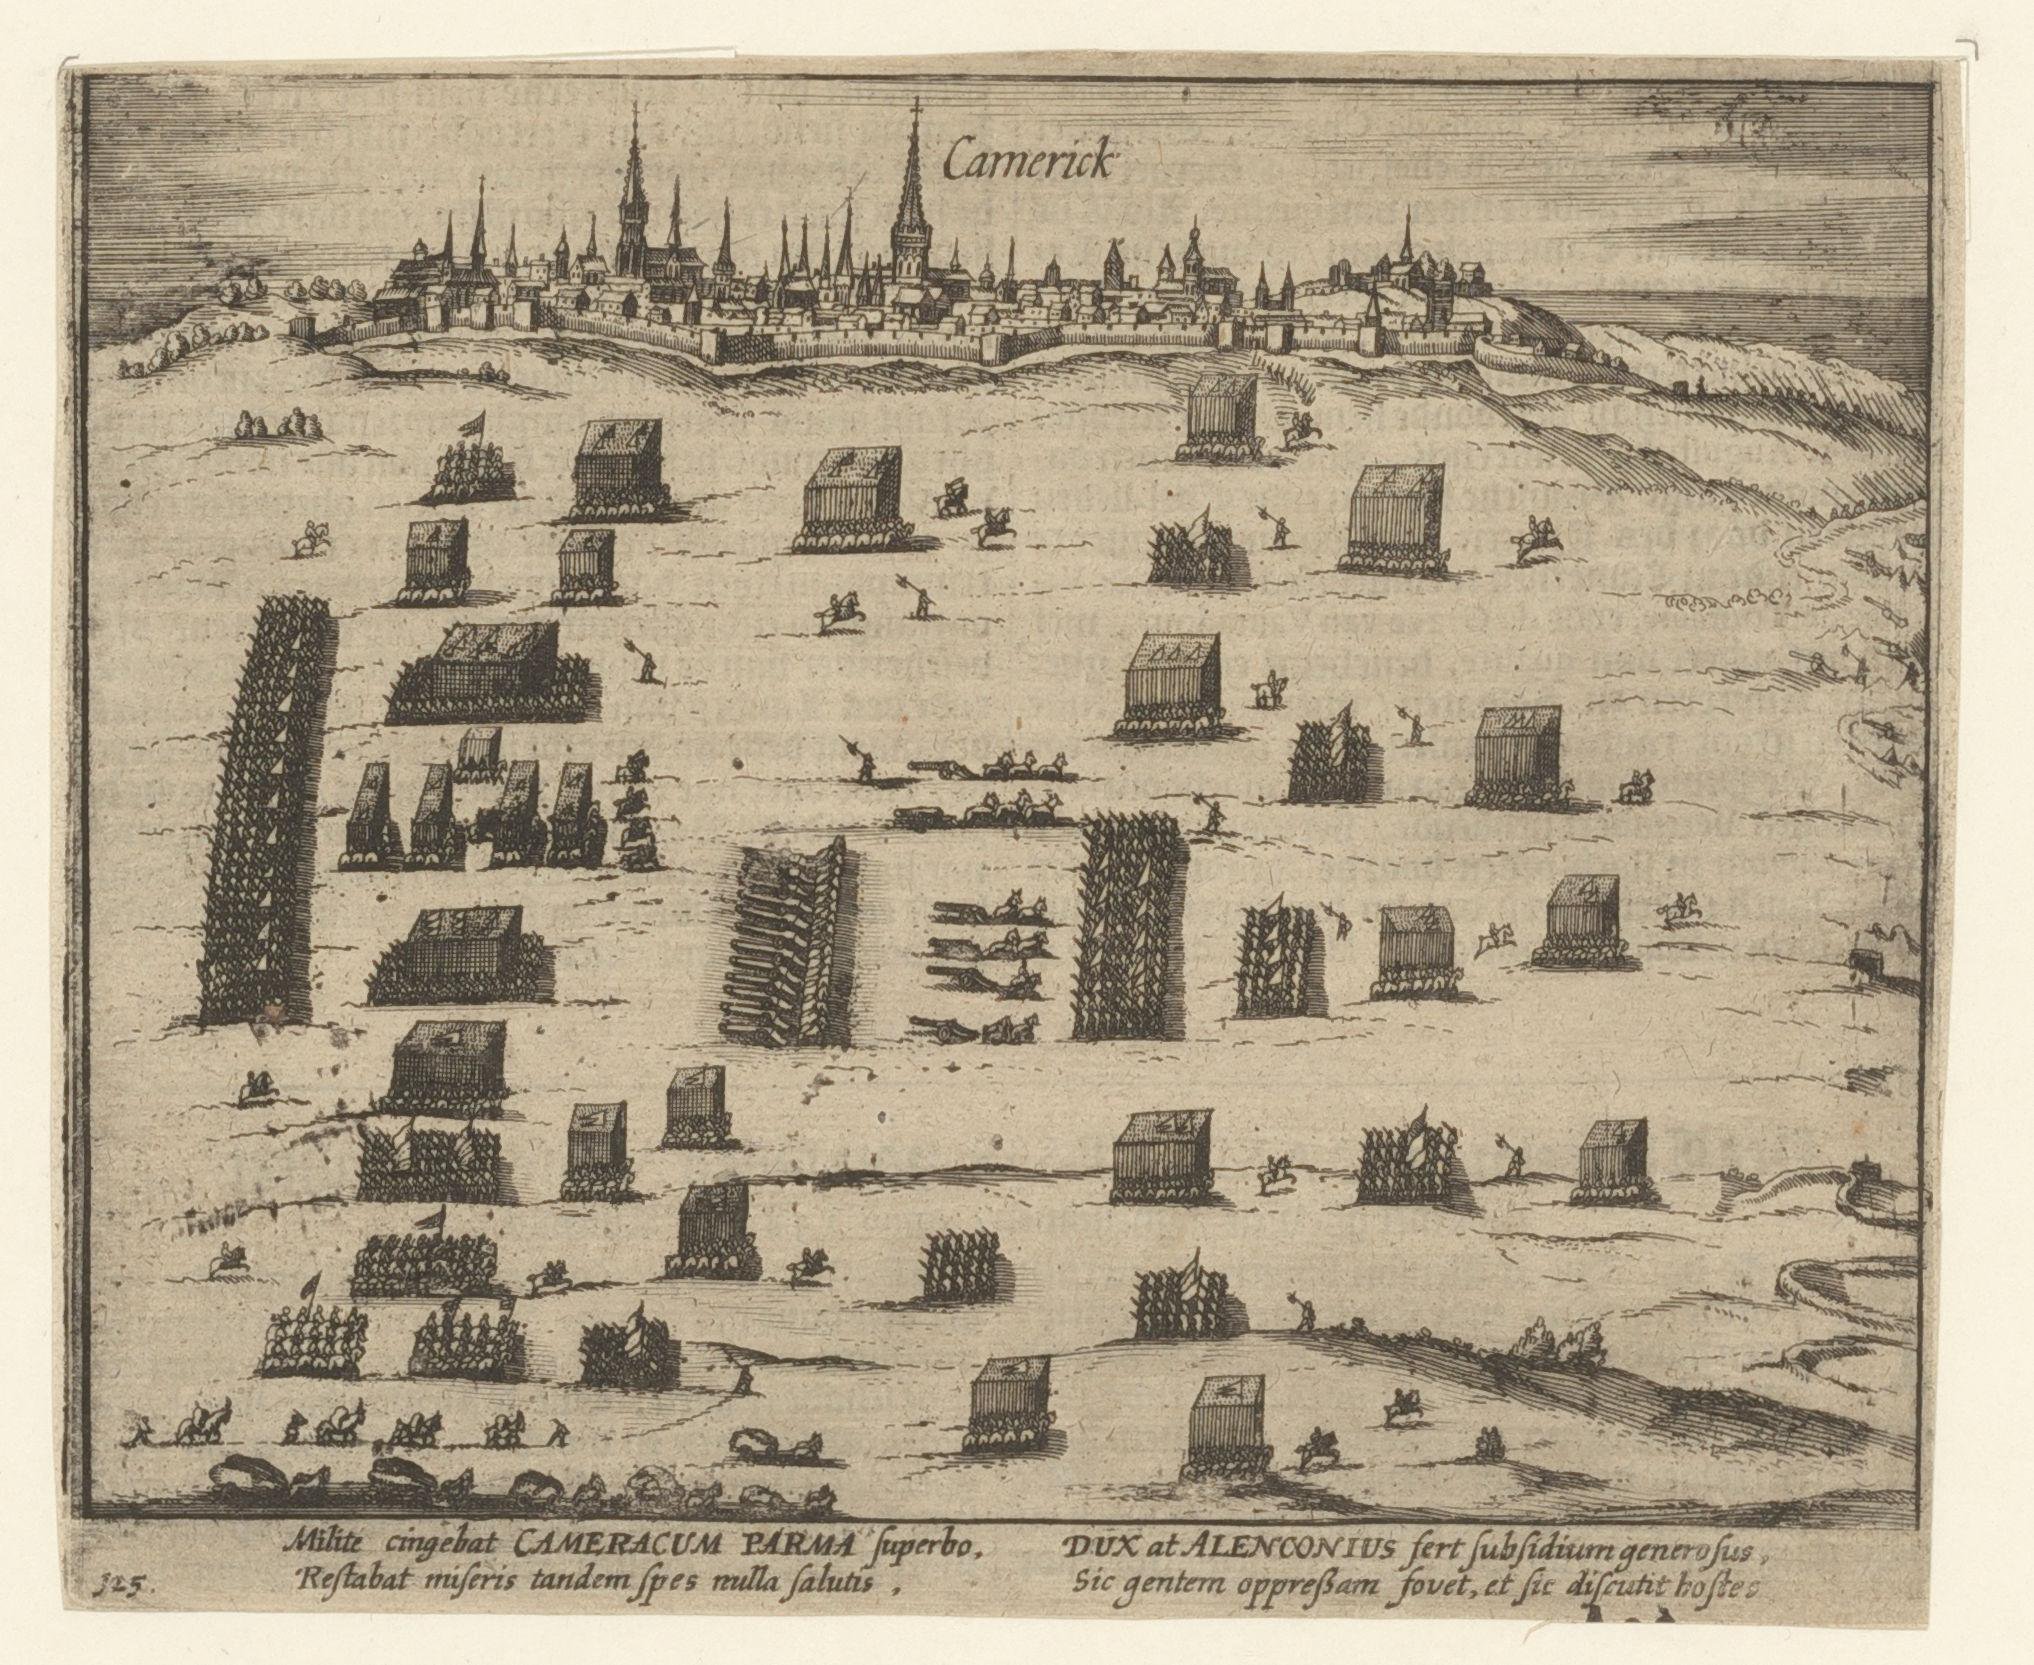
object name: book illustration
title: Kamerijk ontzet door de hertog van Anjou, 1581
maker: Anonymous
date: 1613-1615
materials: paper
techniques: etching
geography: northern netherlands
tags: paris, françois-hercule de valois (hertog van anjou), raising the siege with outside assistance, relief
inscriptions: collector's mark, collector's mark: Lugt 1641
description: Kamerijk belegerd door de troepen van Parma wordt ontzet en van proviand voorzien door de hertog van Anjou, 18 augustus 1581. Het leger van Anjou met wagens met proviand opgesteld voor de stad. Met onderschrift van 4 regels in het Latijn. Genummerd 125. Bedrukt op achterzijde met tekst in het Nederlands. Onderwerpsrubrieken binnen de Atlas Zeden en Gewoonten: Krijgswezen; prenten van Baudart. 80j. oorlog.